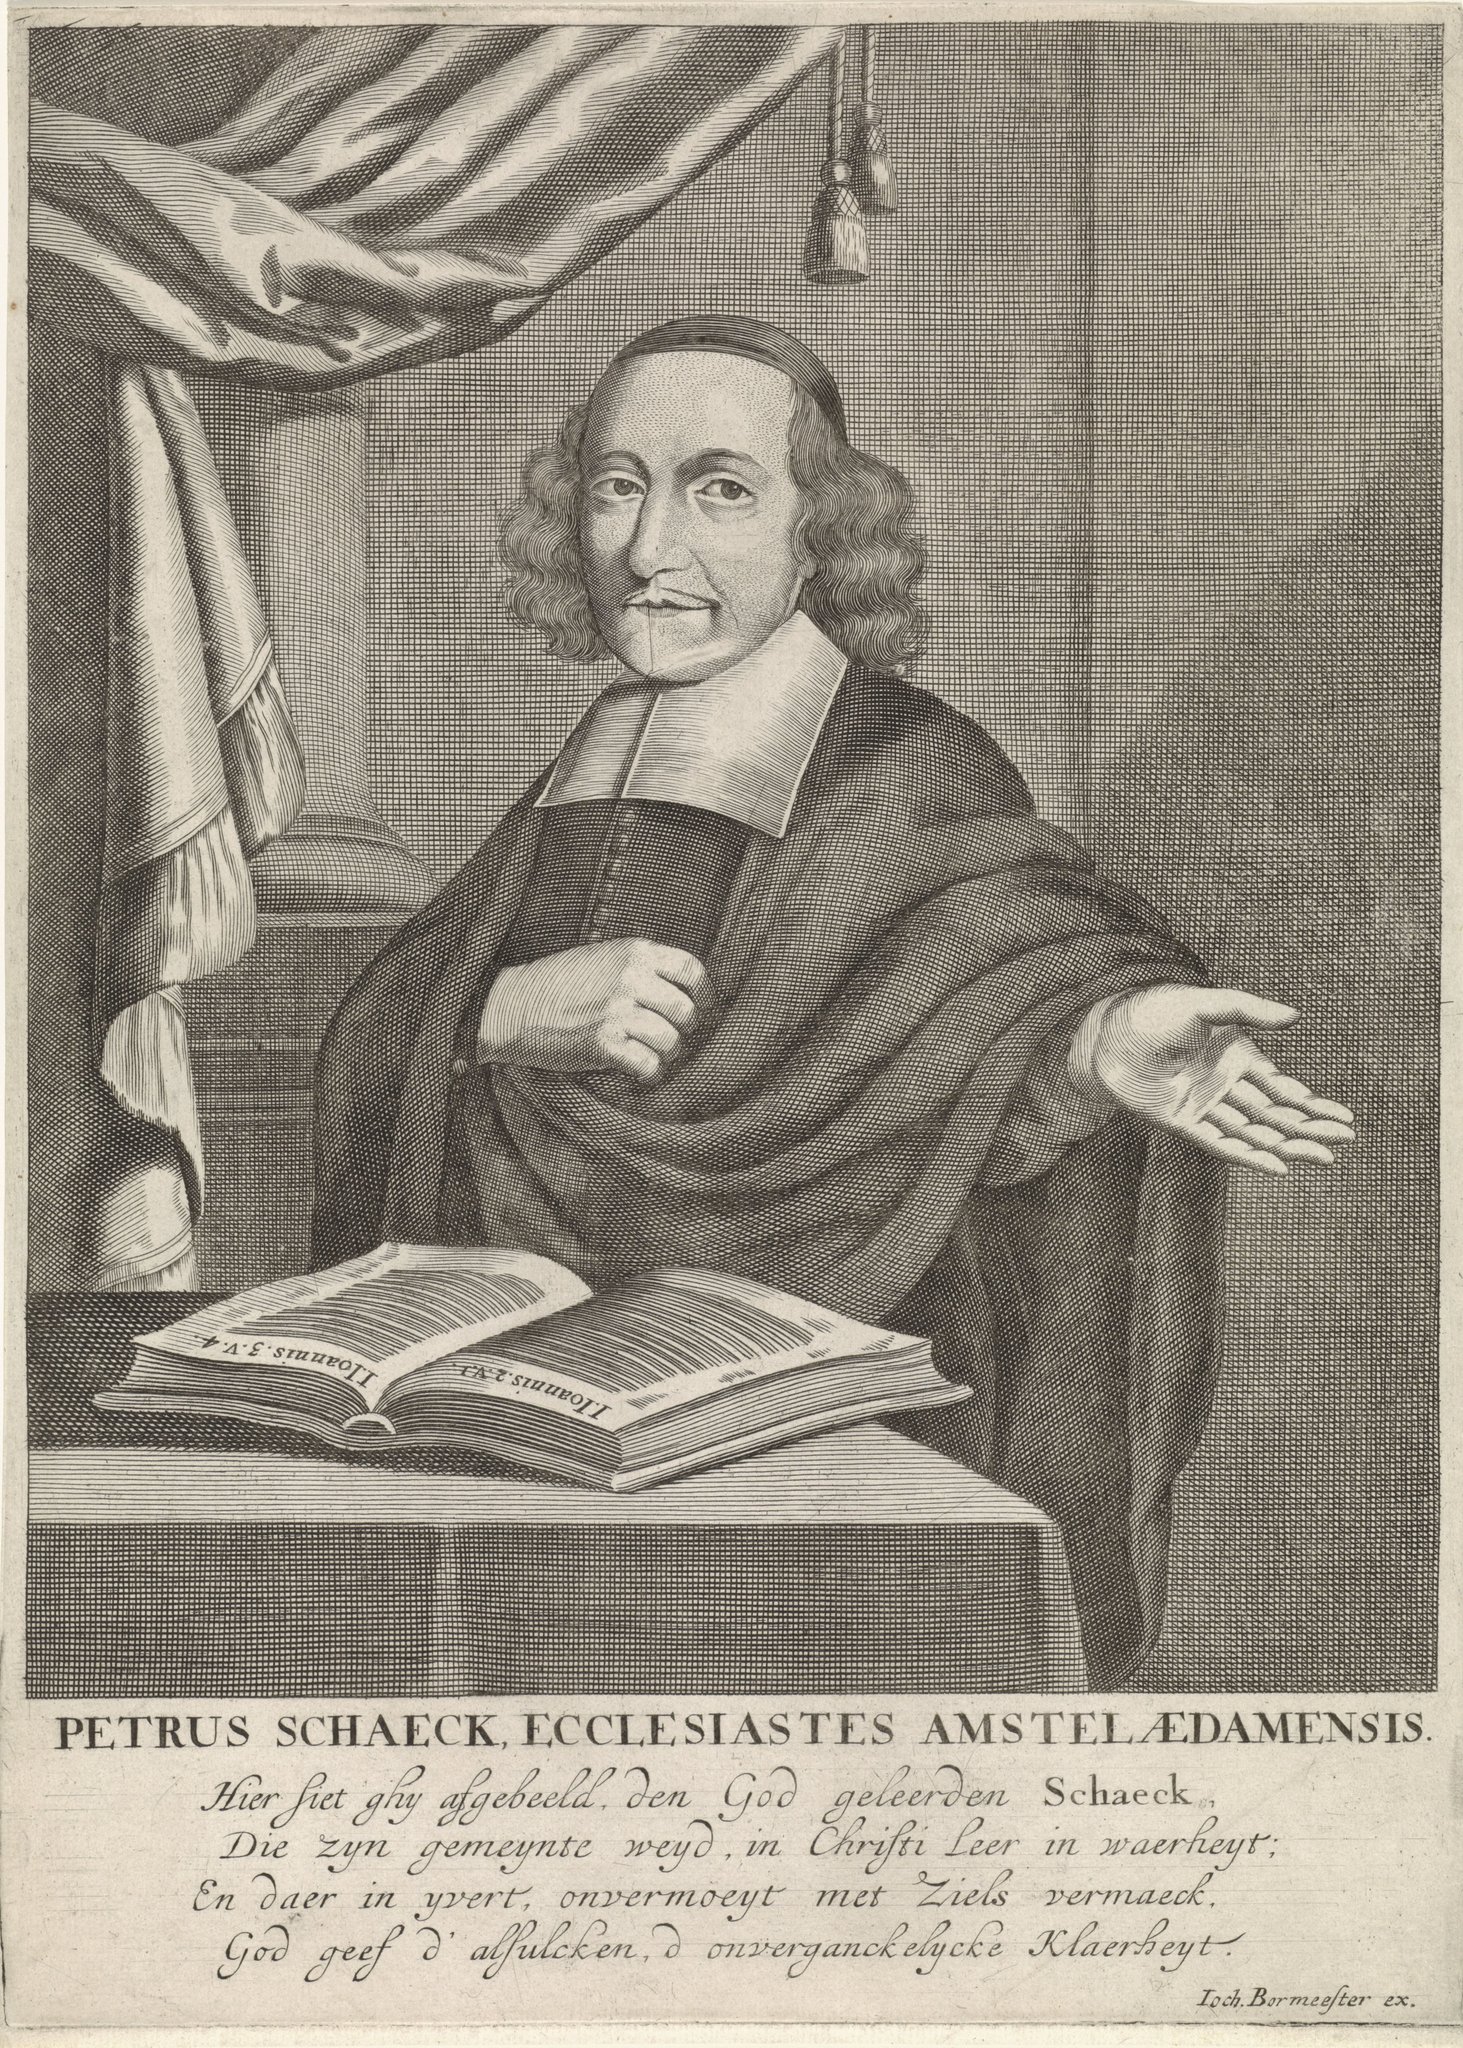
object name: print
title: Portret van de Amsterdamse predikant Petrus Schaeck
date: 1677-1702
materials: paper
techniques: engraving, etching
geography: amsterdam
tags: predikant, petrus schaeck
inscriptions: collector's mark: Lugt 2228